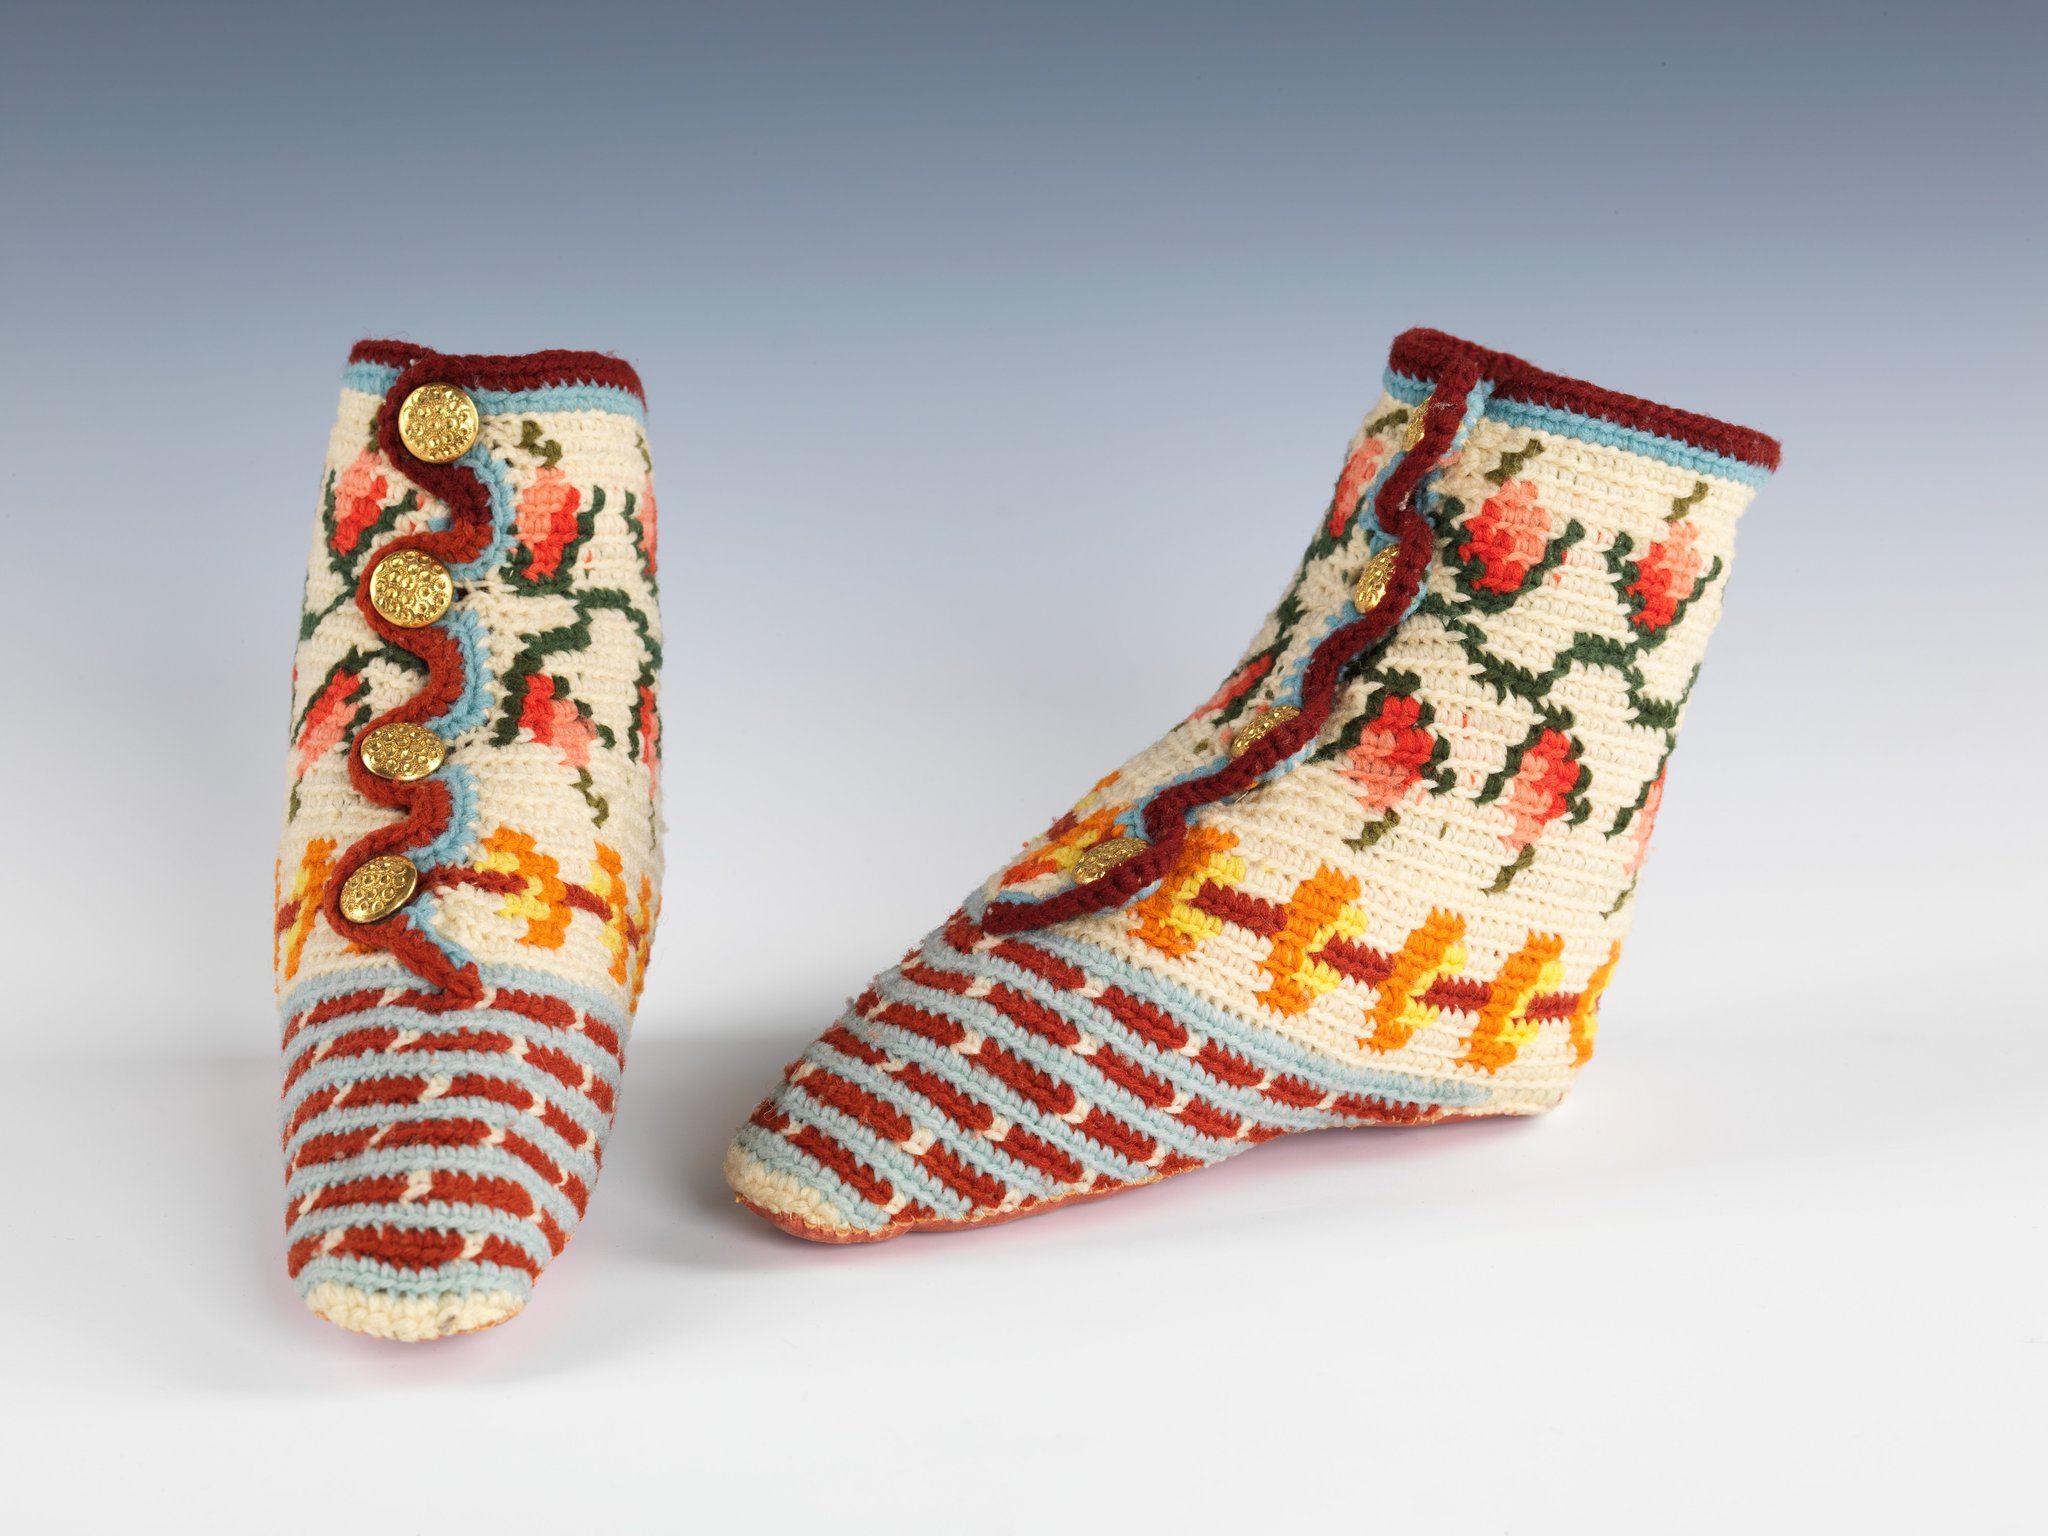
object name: bootee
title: Bootees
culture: american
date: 1870-1880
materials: leather, metal, wool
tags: flowers